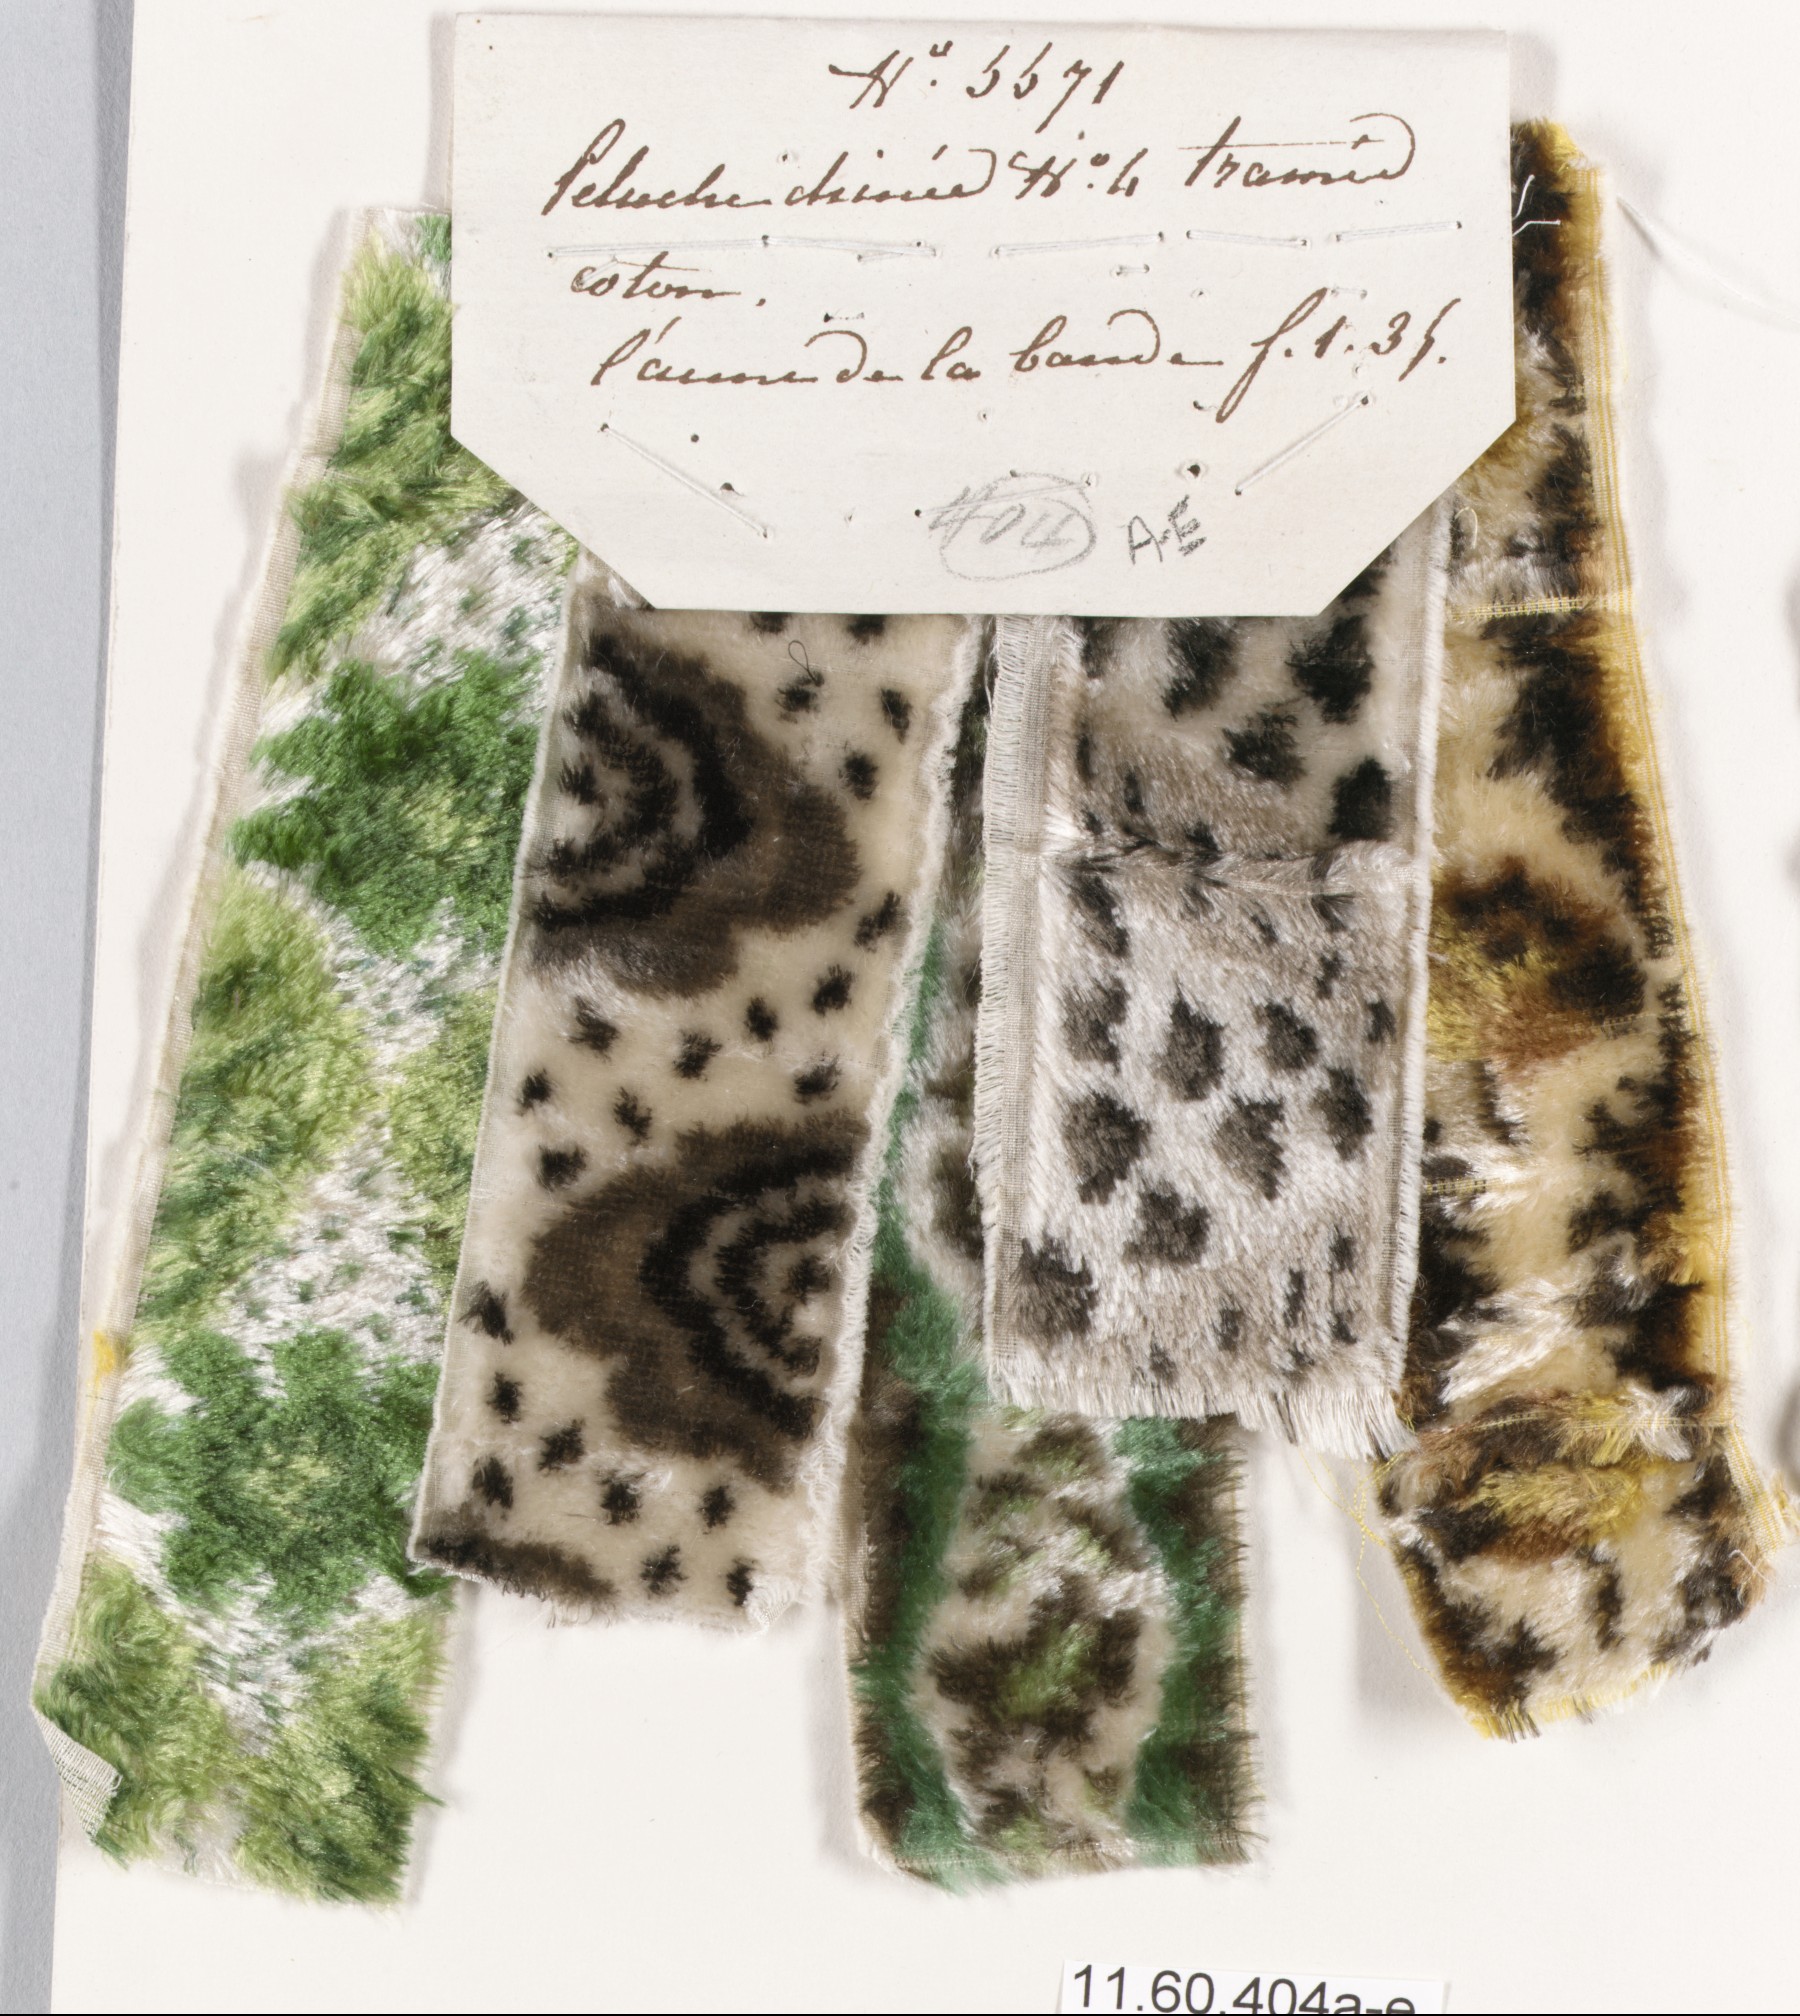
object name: fragment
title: Fragments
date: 1801-1900